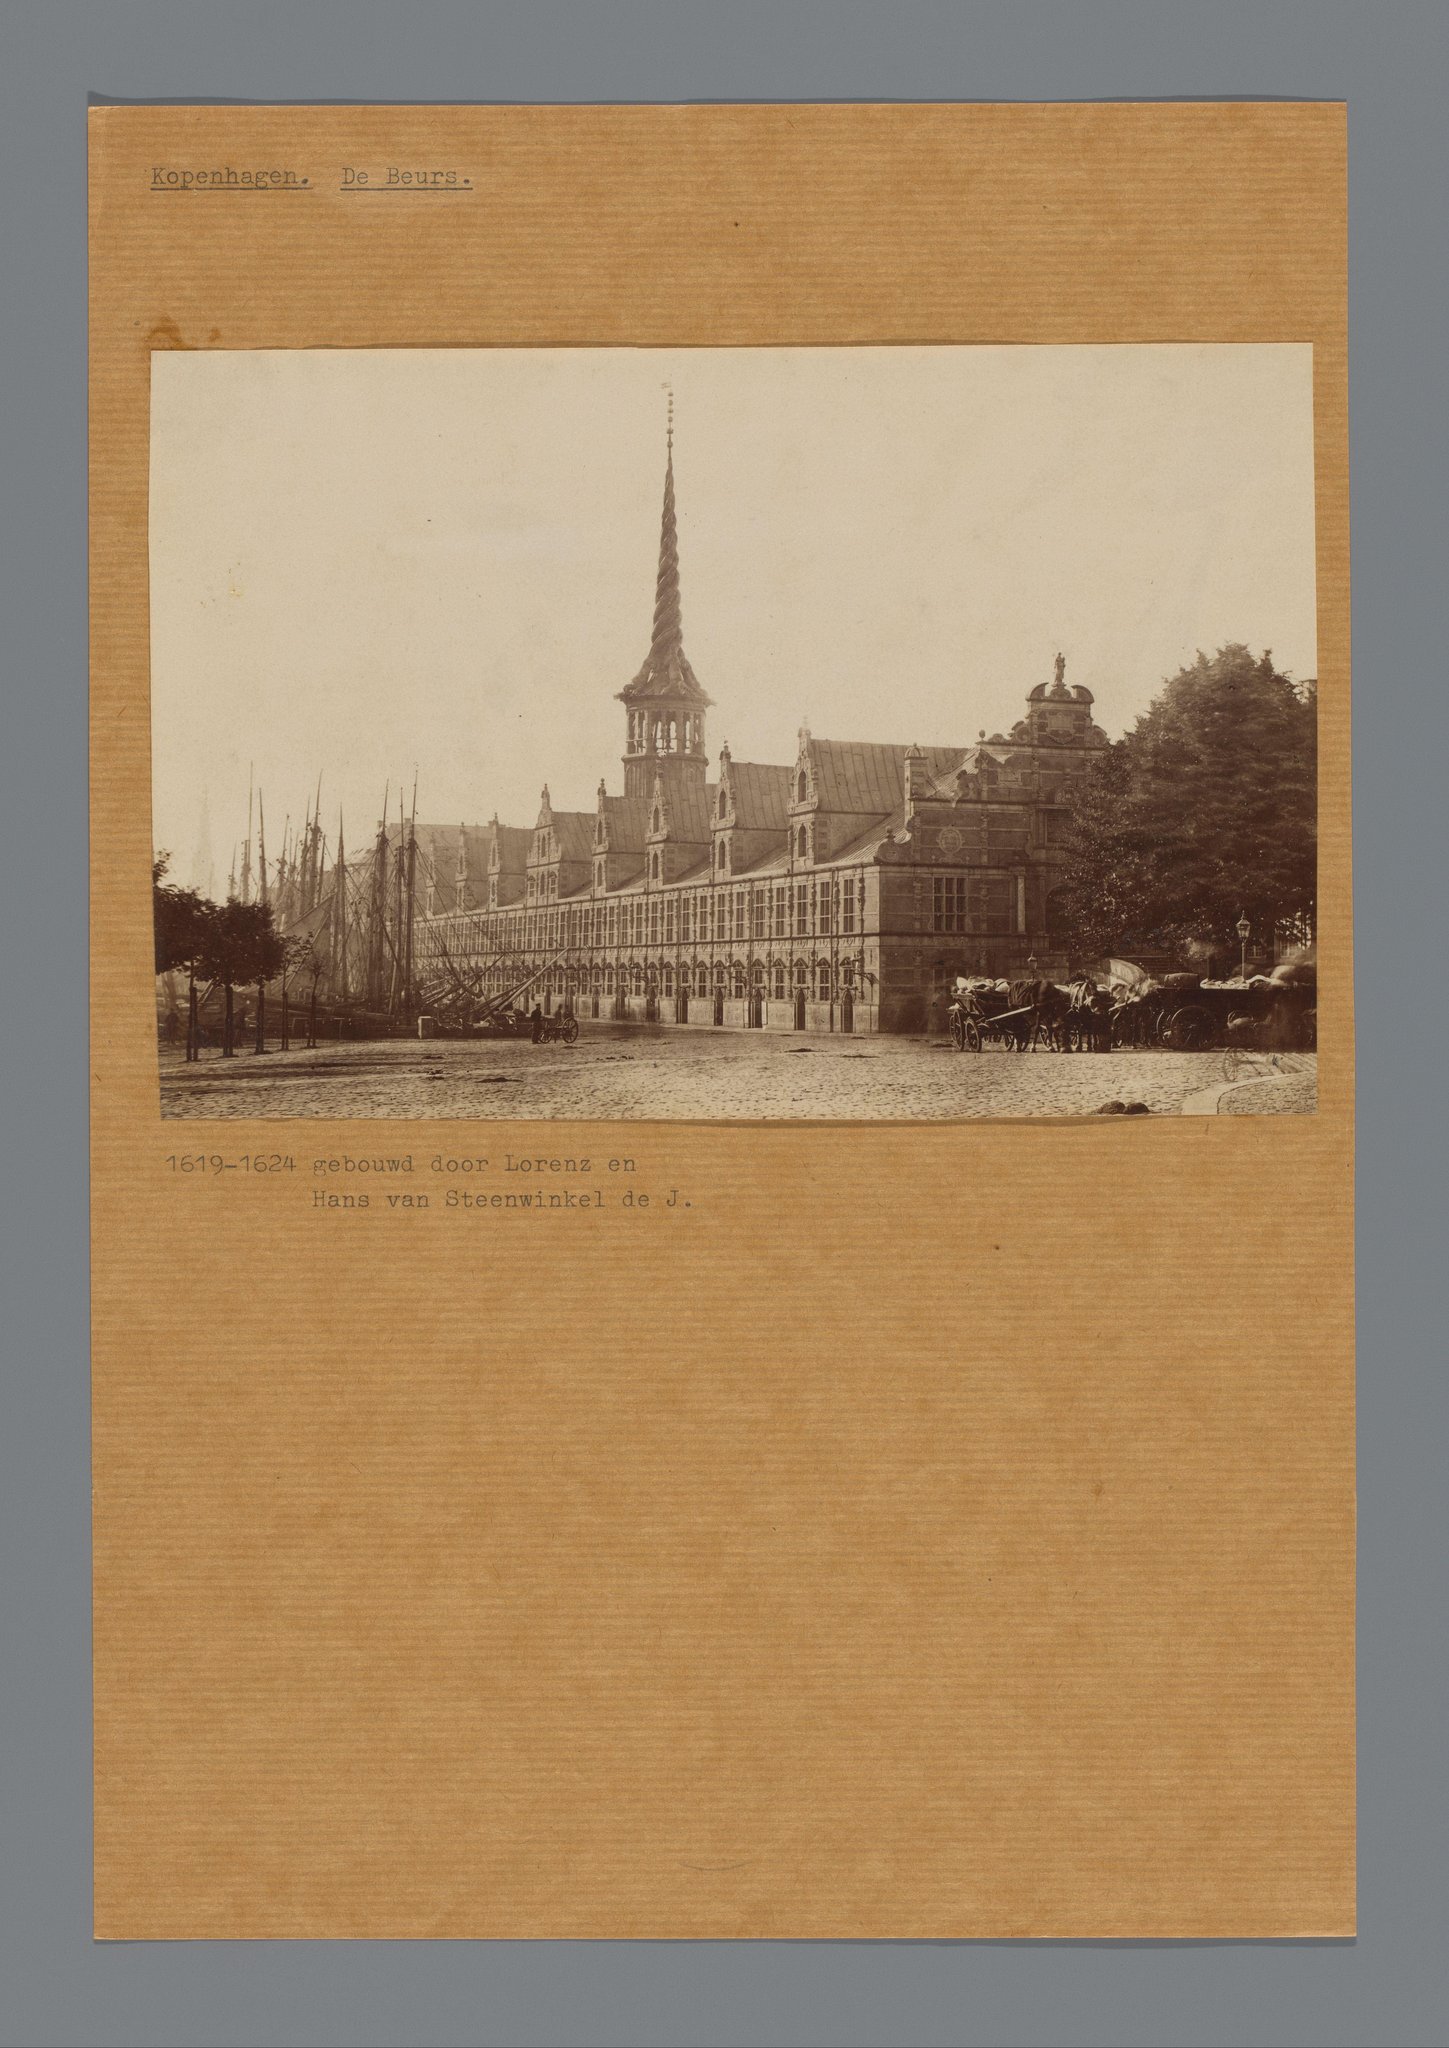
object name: photograph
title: Kopenhagen. De beurs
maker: Anonymous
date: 1850-1900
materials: photographic support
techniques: albumen print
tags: copenhagen (city)